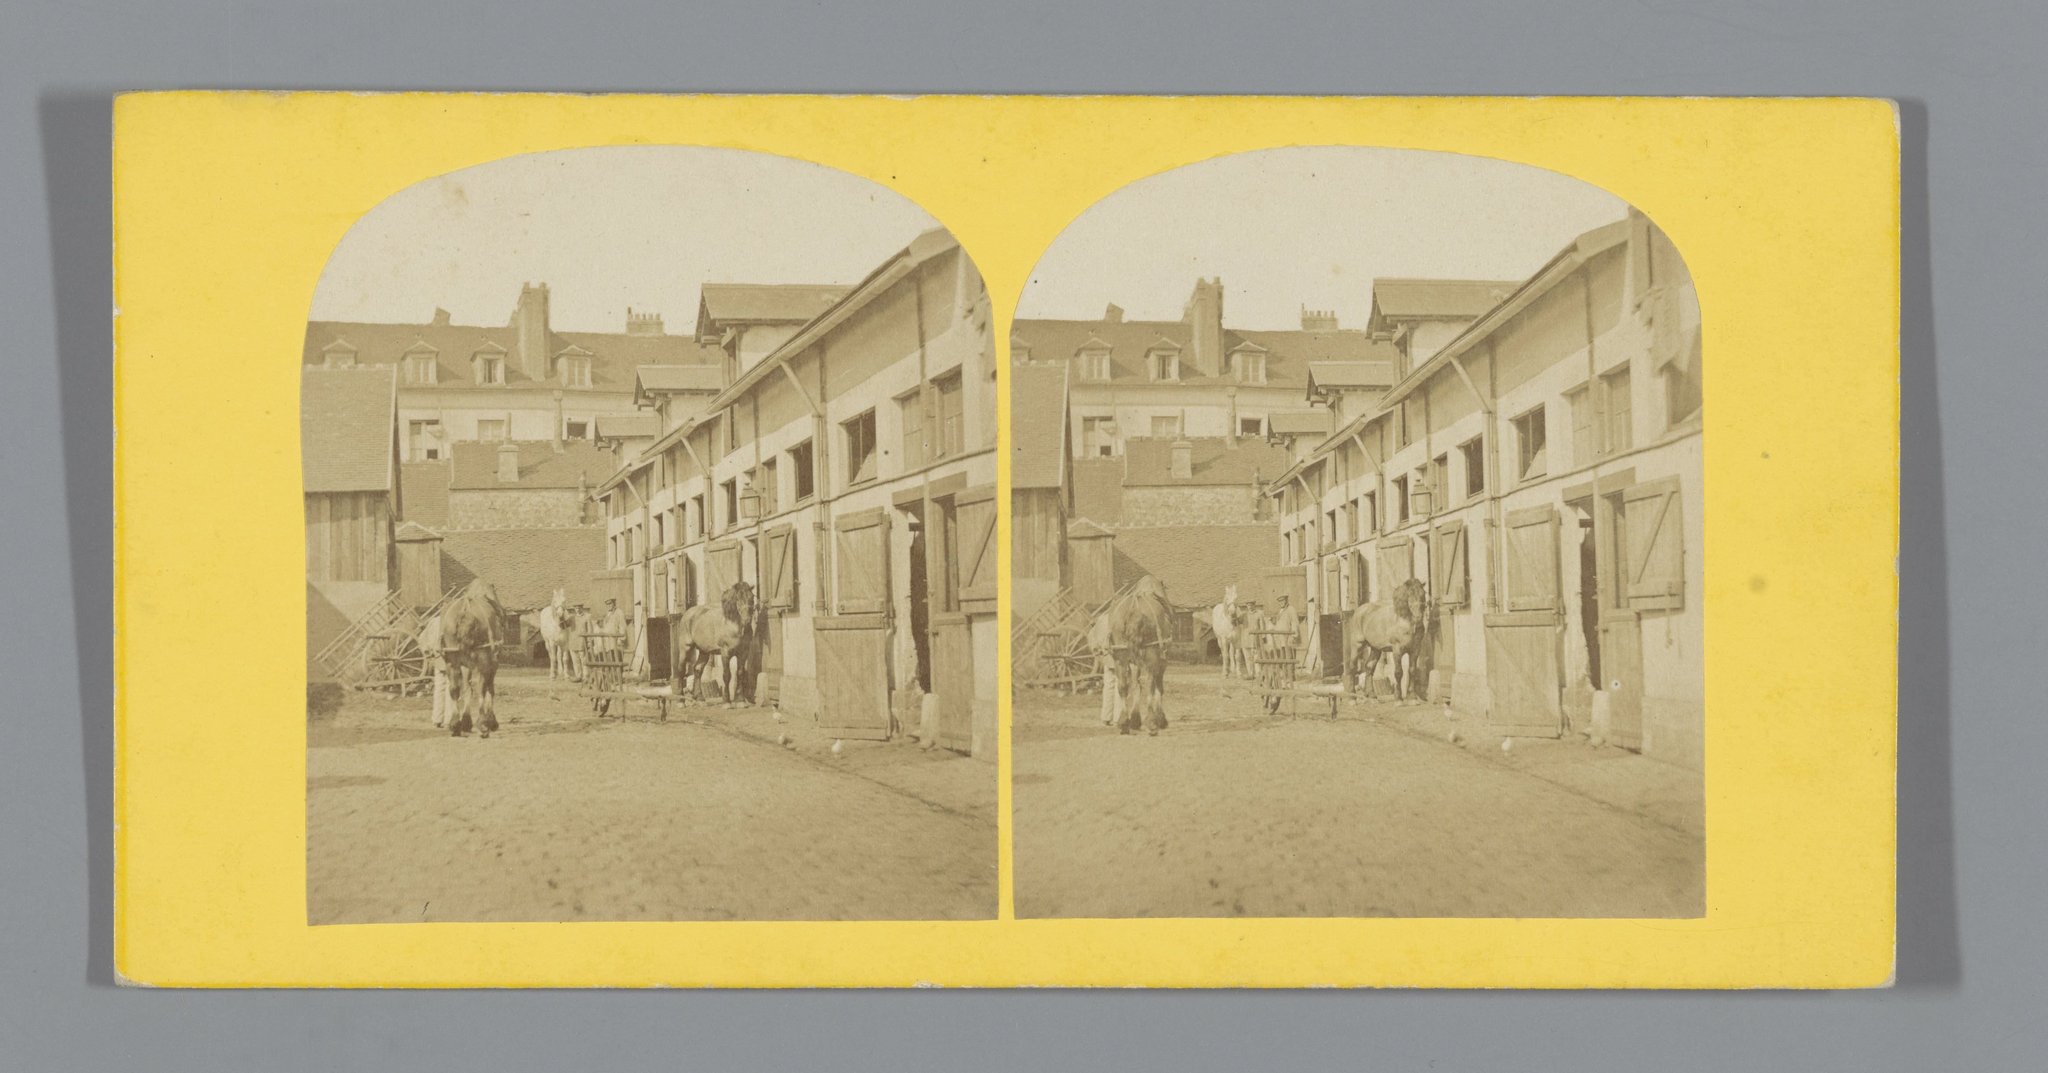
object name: stereograph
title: Paardenstallen (vermoedelijk) te Frankrijk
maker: Anonymous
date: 1860-1870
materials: cardboard, photographic support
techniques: albumen print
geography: france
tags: stall, stable